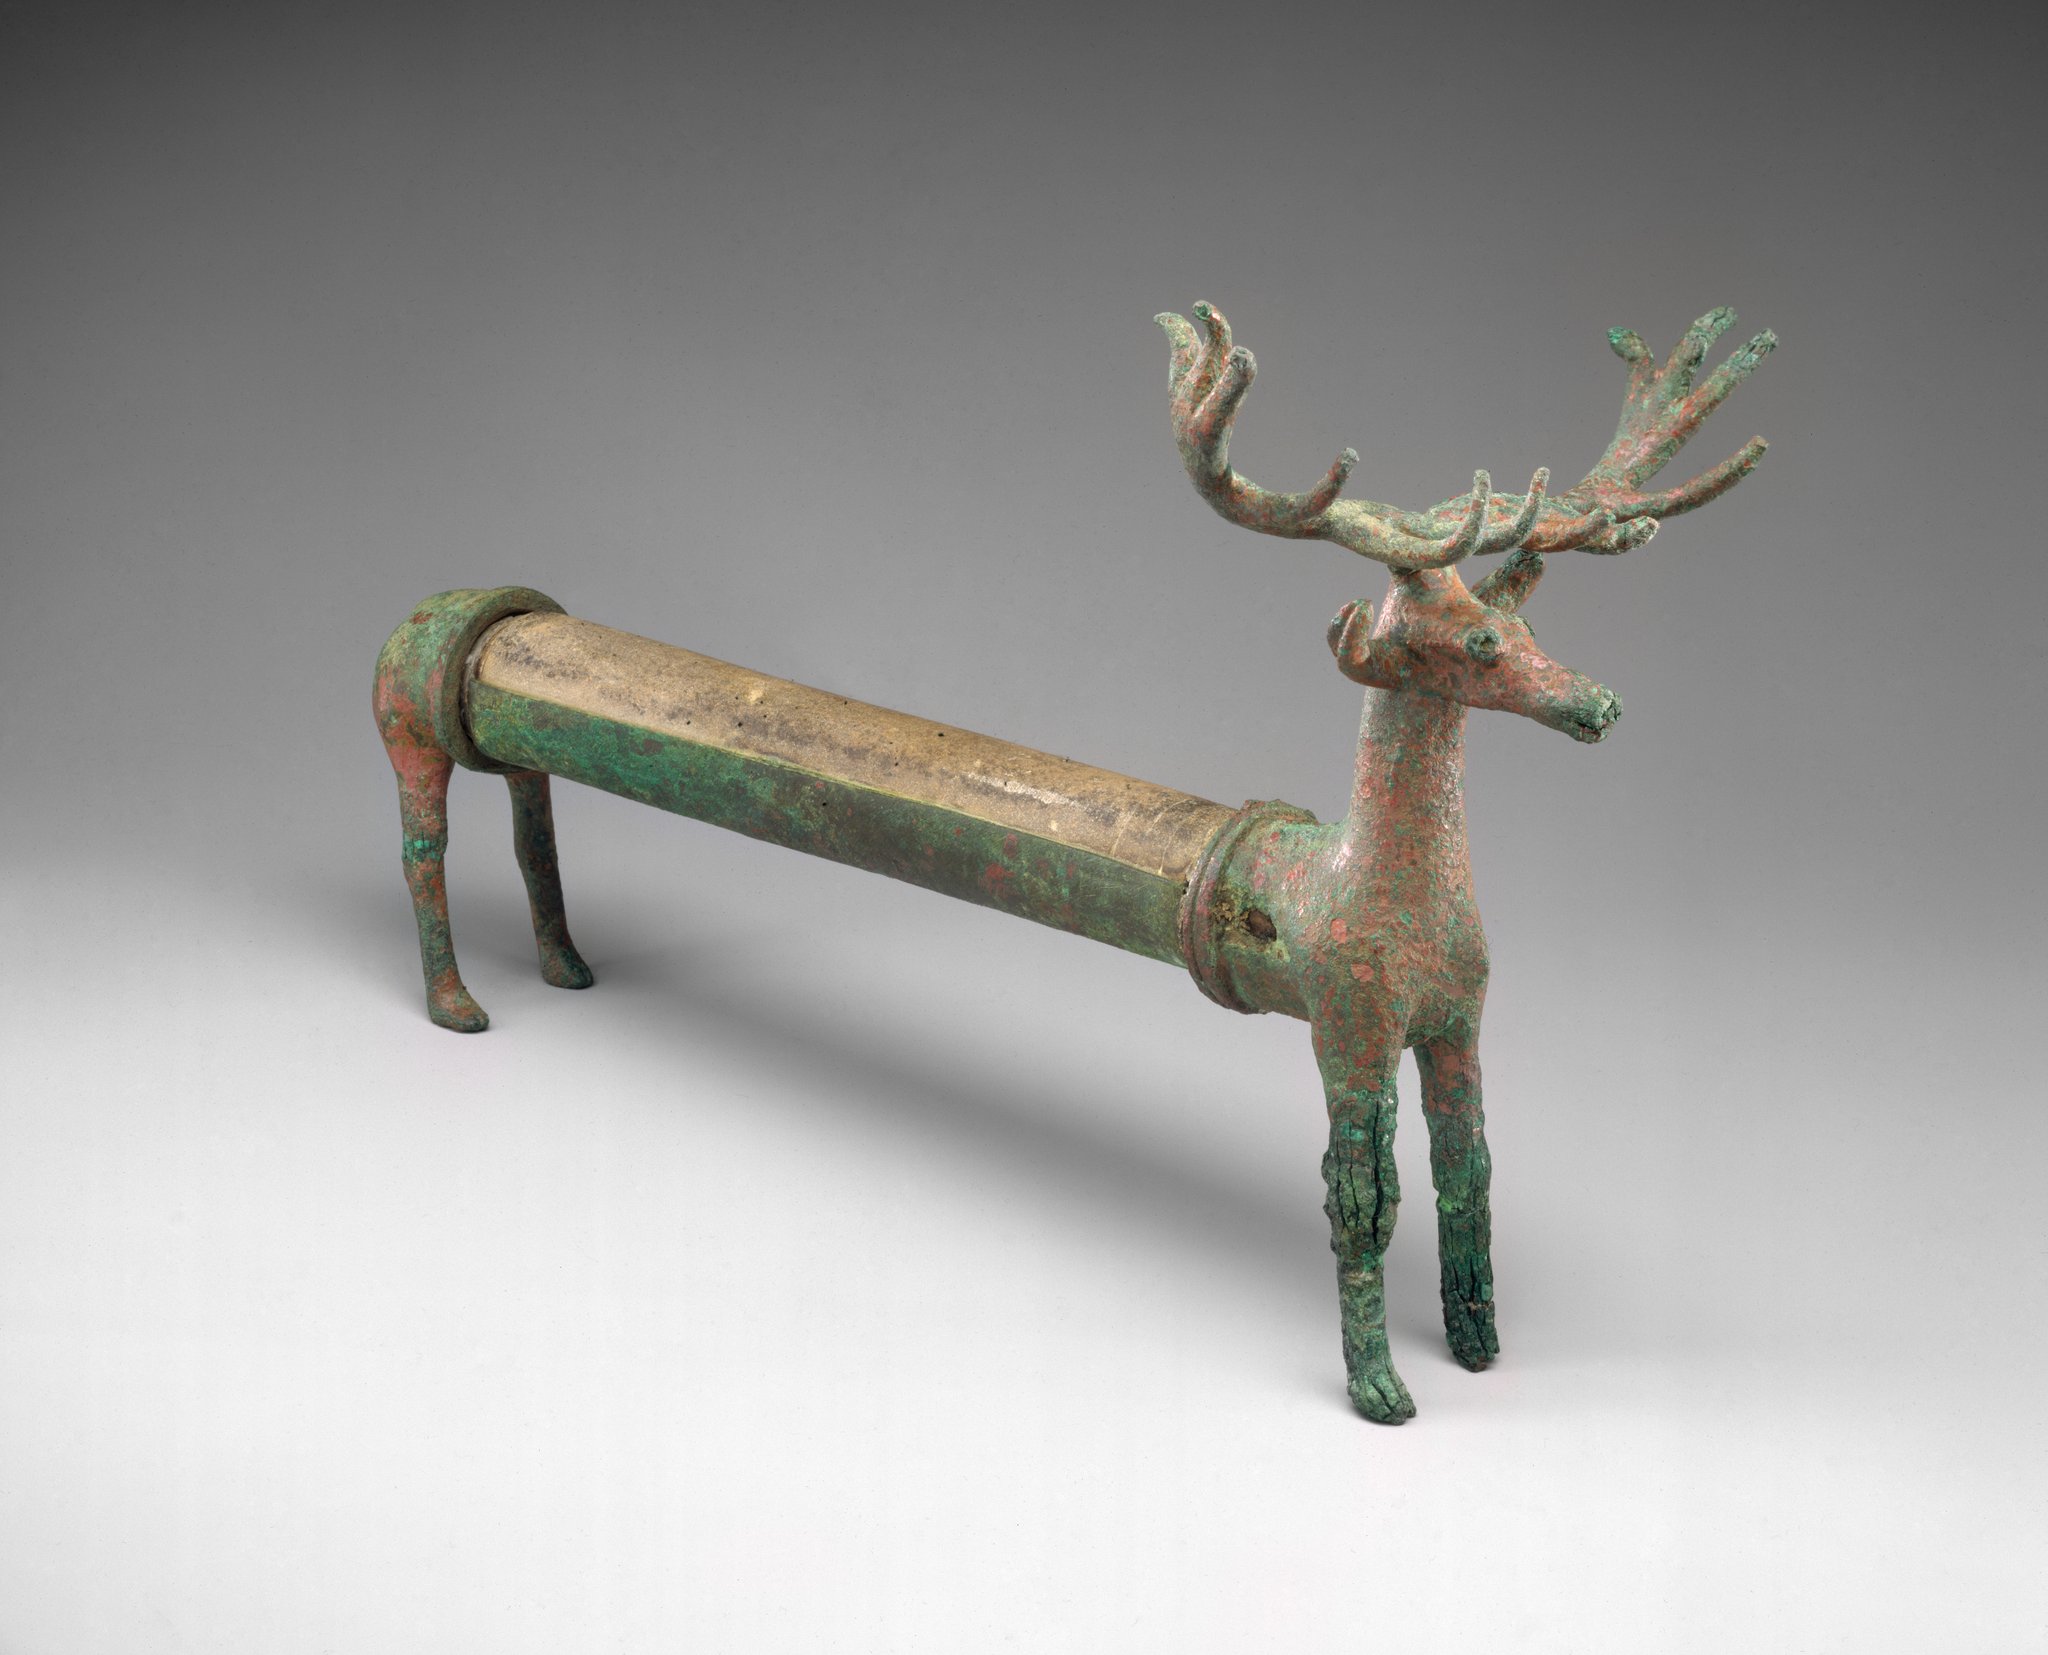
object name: whetstone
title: Whetstone in the form of a stag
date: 1000-668 BCE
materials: bronze, stone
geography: transcaucasia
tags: deer